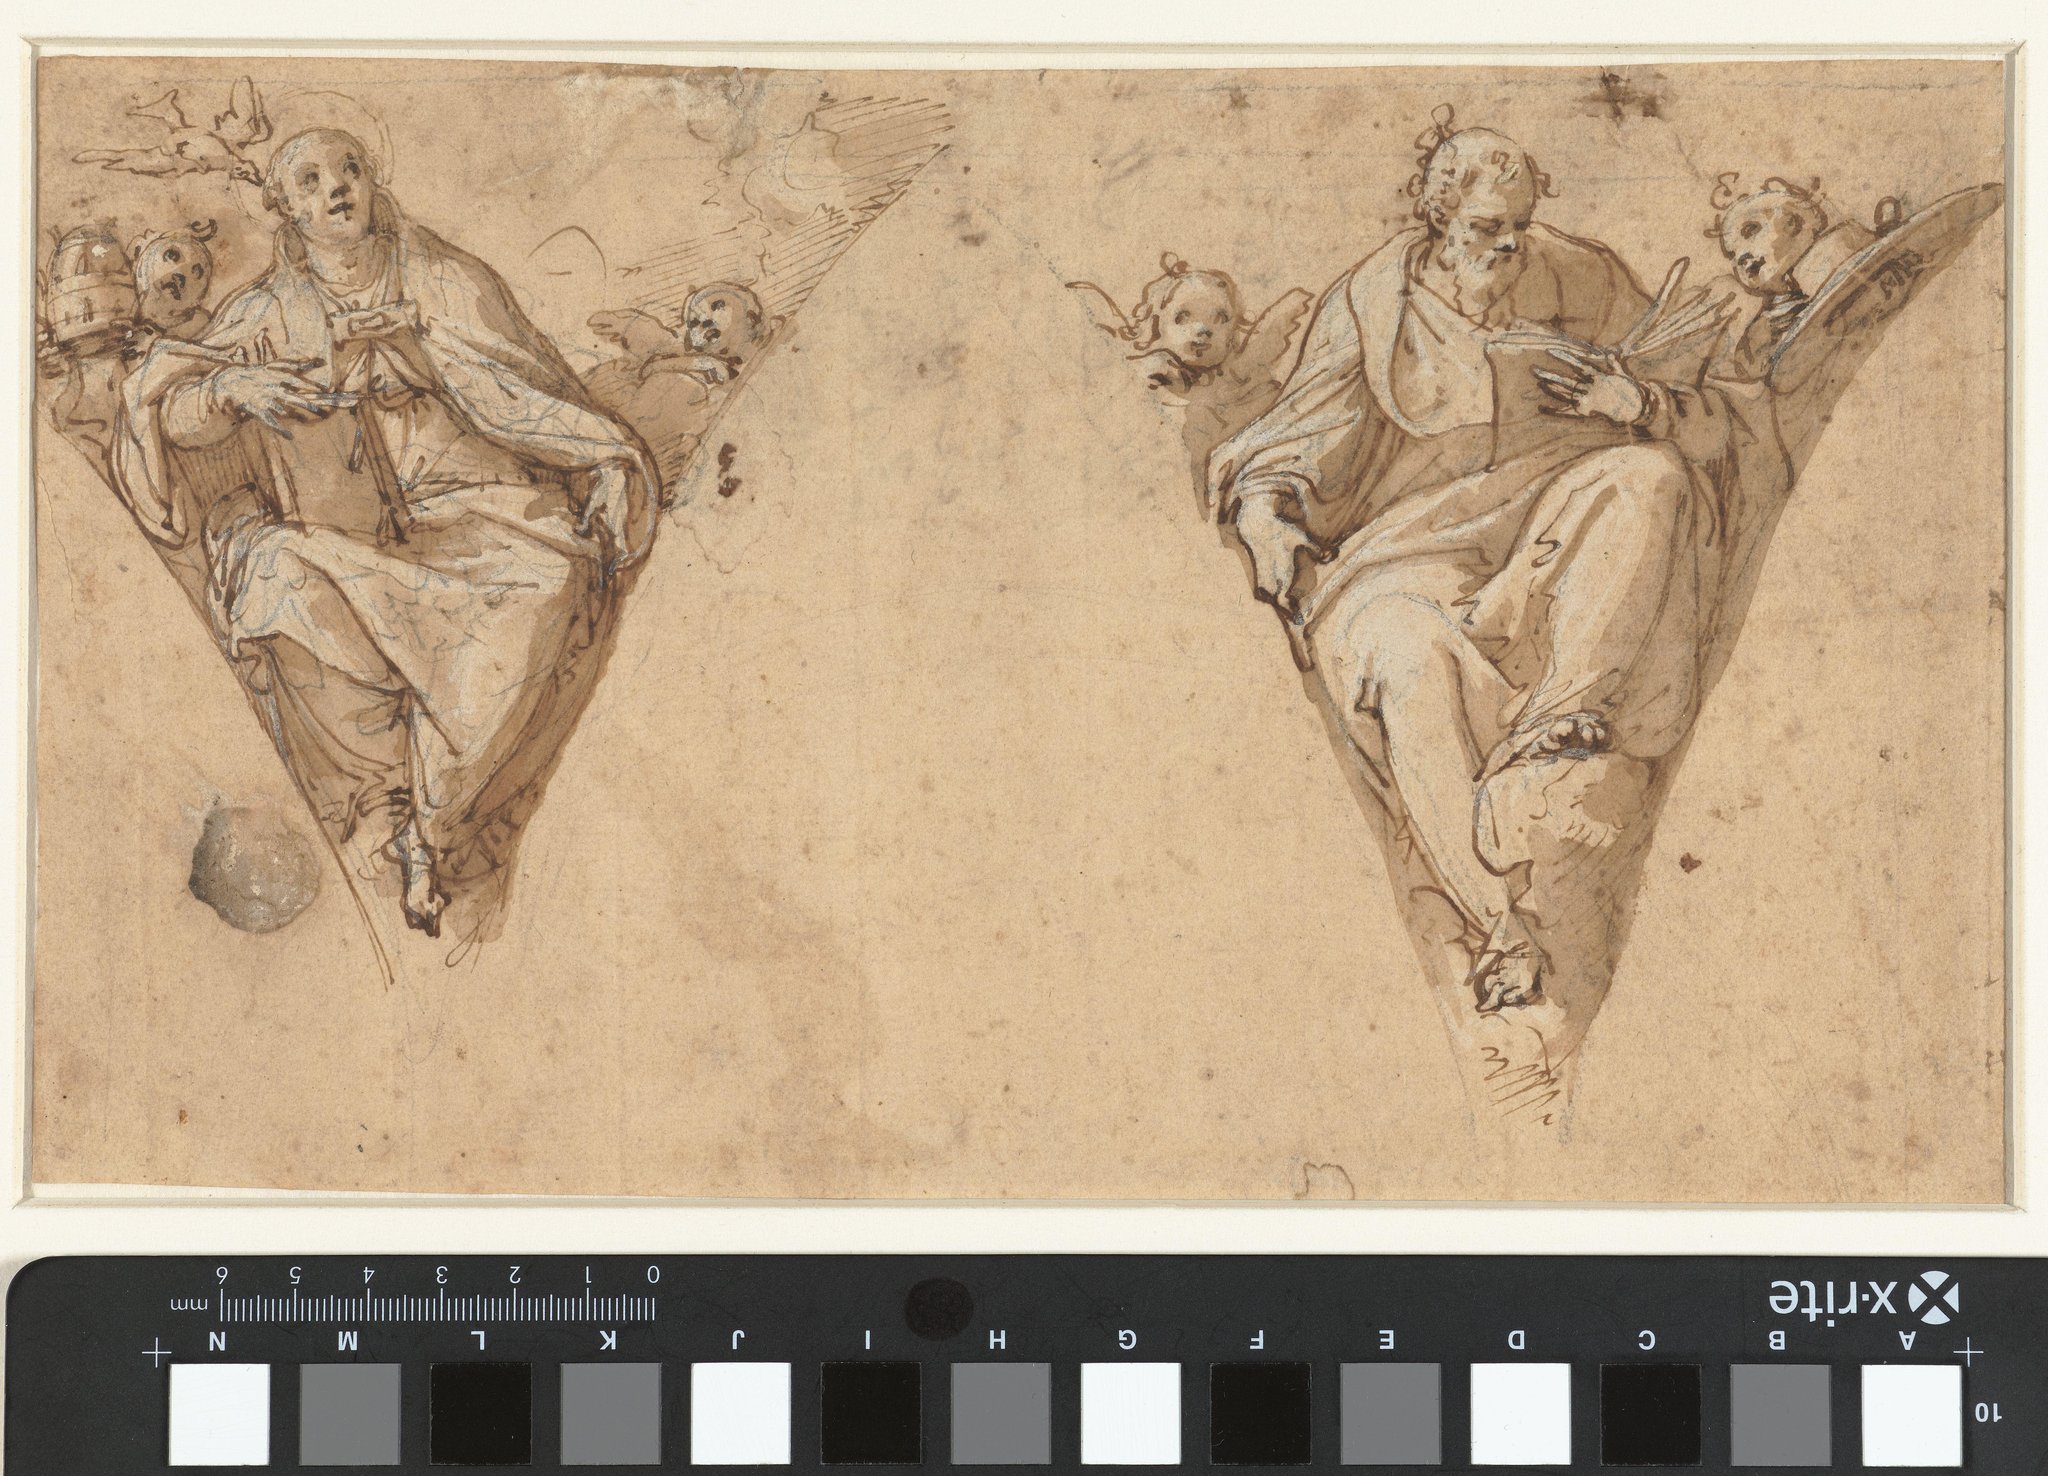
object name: drawing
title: Twee zittende kerkvaders in zwikken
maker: giulio morina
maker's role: draughtsman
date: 1580-1600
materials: chalk, ink, paper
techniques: brush, pen